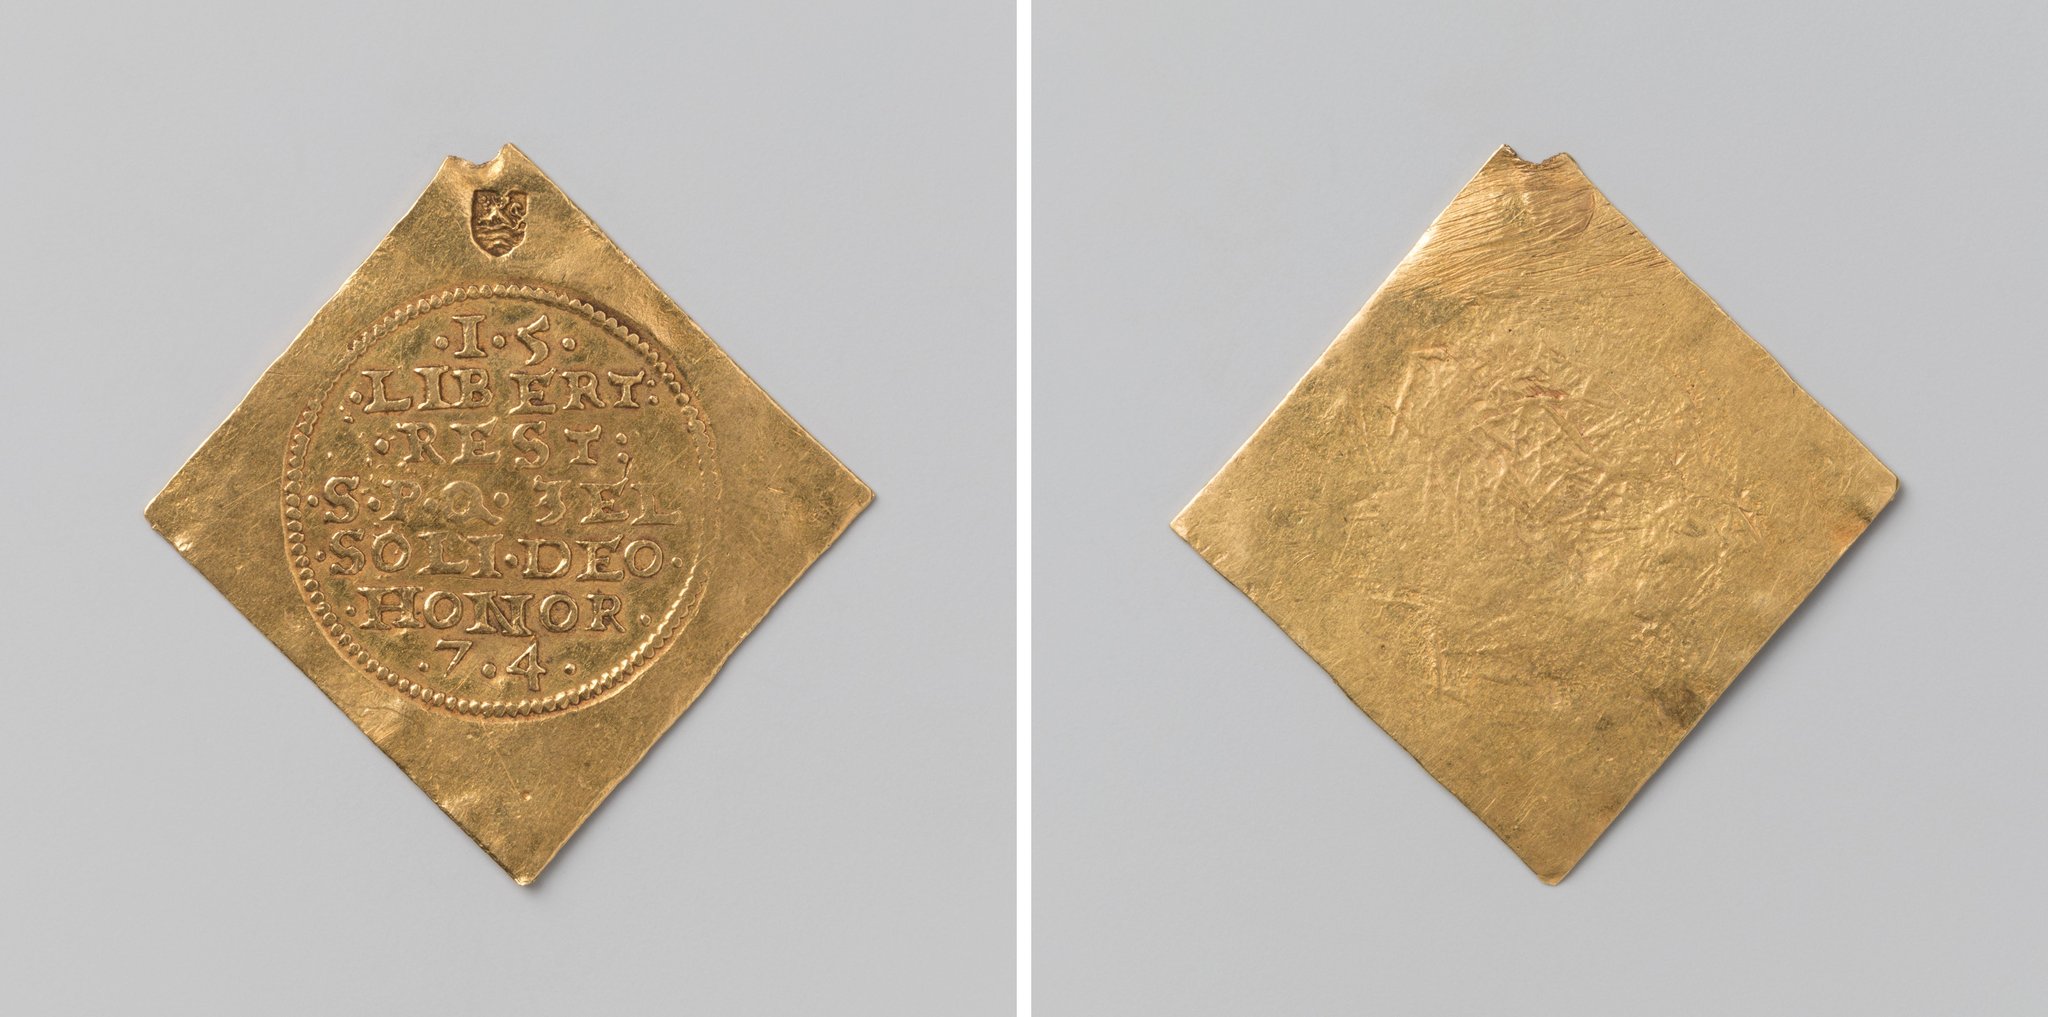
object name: coin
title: Kroon, noodmunt uit Middelburg, geslagen na het beleg en de inname van de stad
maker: Anonymous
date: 1503-1574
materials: gold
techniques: striking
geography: middelburg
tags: middelburg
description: eenzijdige, ruitvormige noodmunt. Voorzijde: twee stempels boven elkaar: bovenste stempel: wapenschild; daaronder: opschrift in ronde parelrand. Keerzijde: blanco